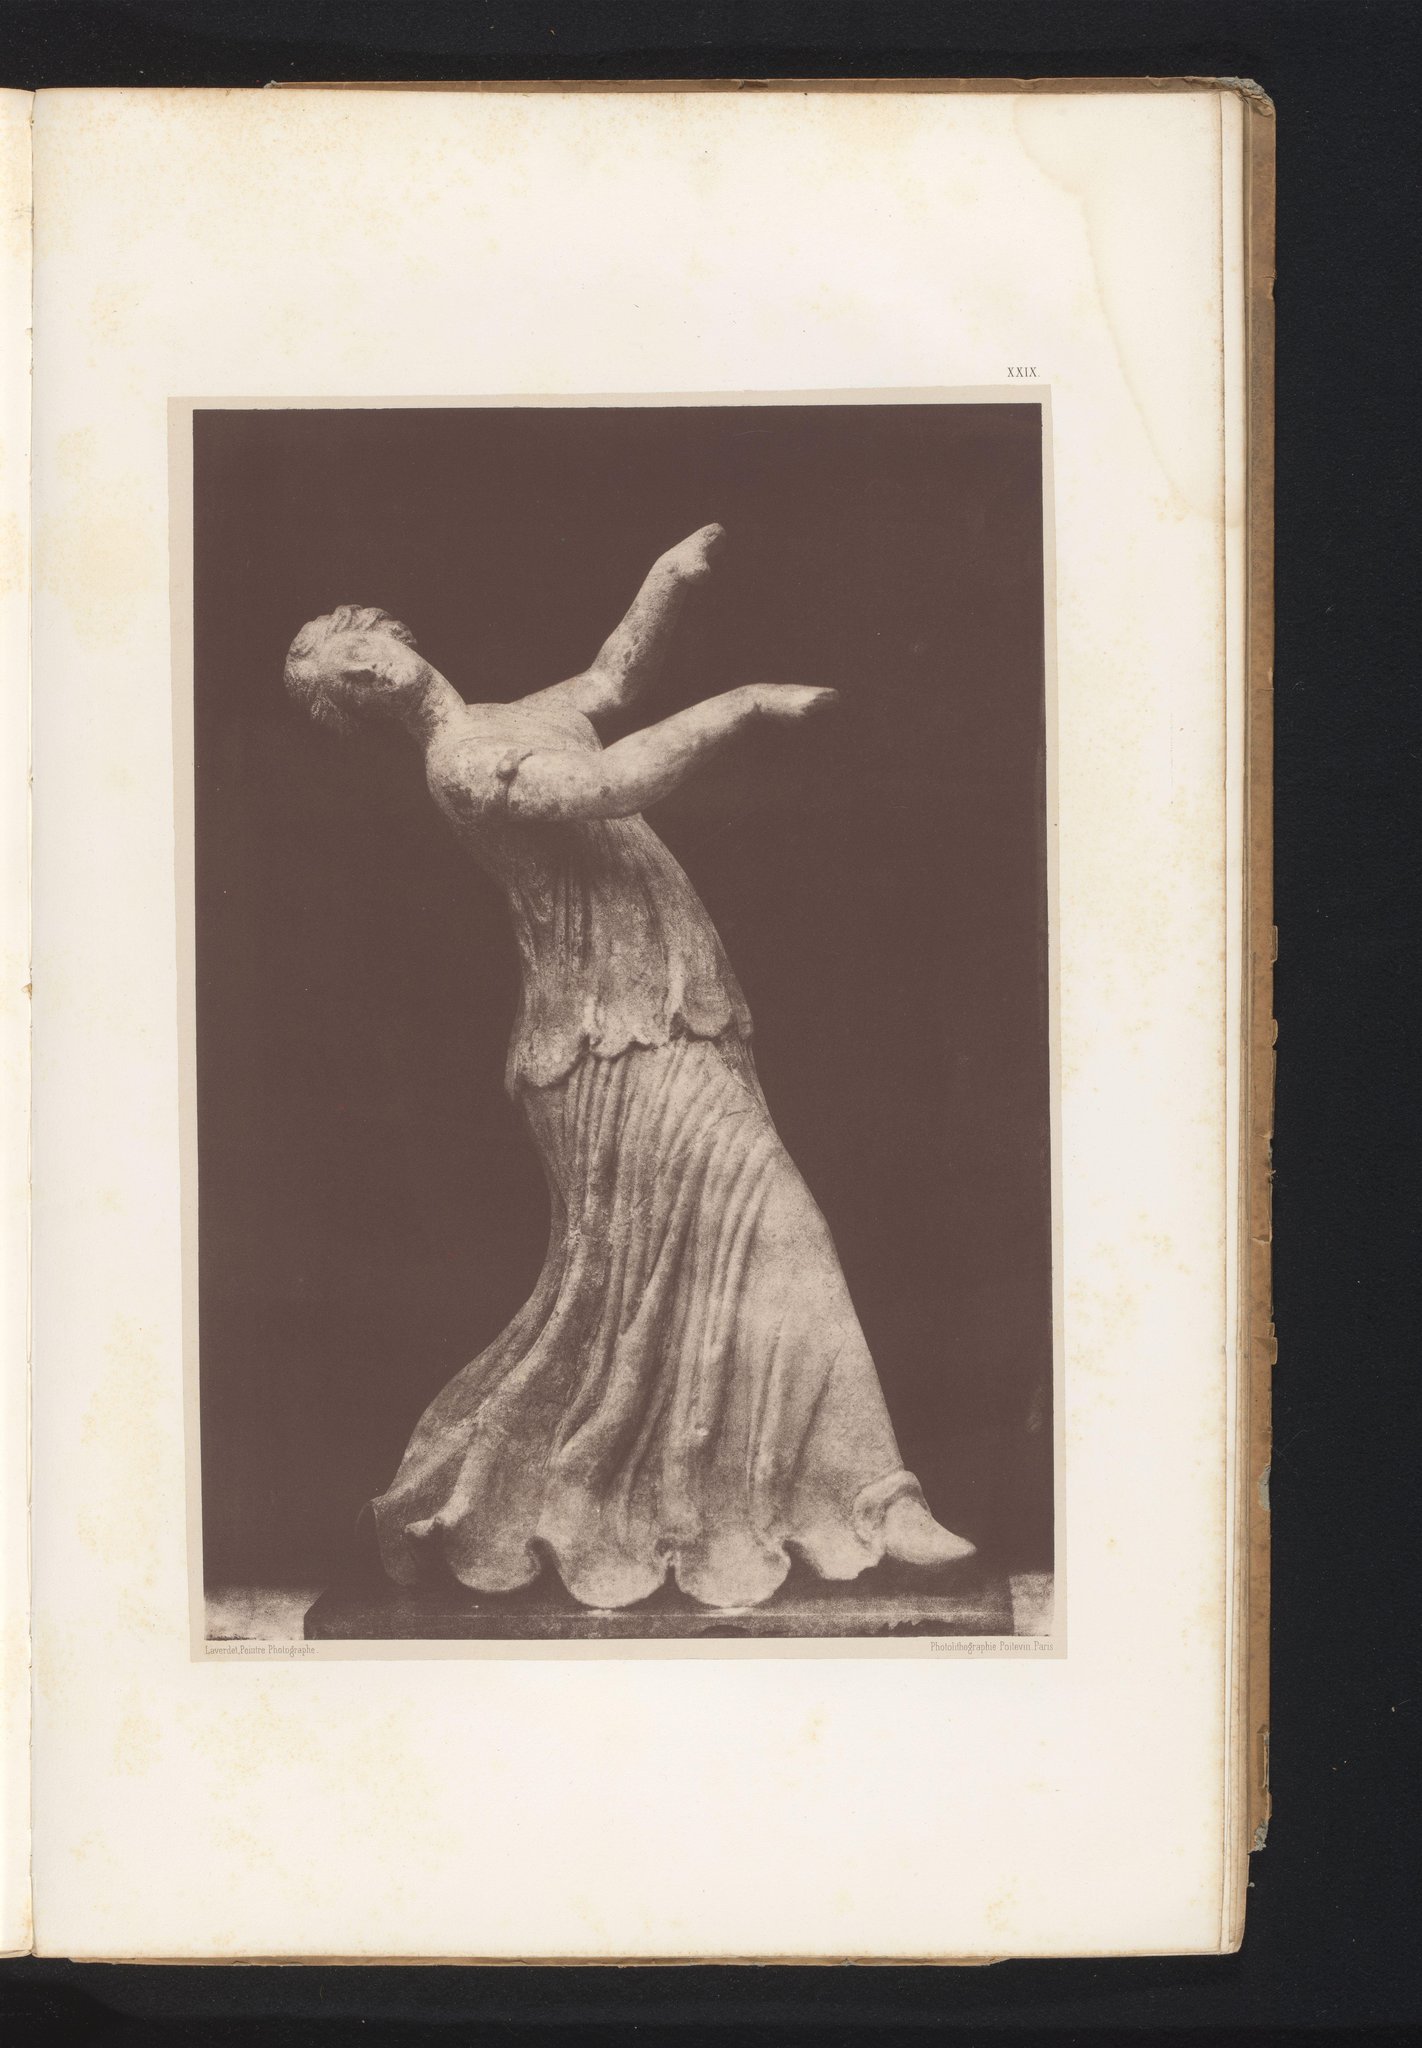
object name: page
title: Terracotta sculptuur van een dansende vrouw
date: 1852-1857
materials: paper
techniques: photolithography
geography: paris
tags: woman dancing alone, piece of sculpture, reproduction of a piece of sculpture (+ clay, sand, etc. ~ arts)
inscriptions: number: ‘XXIX.’